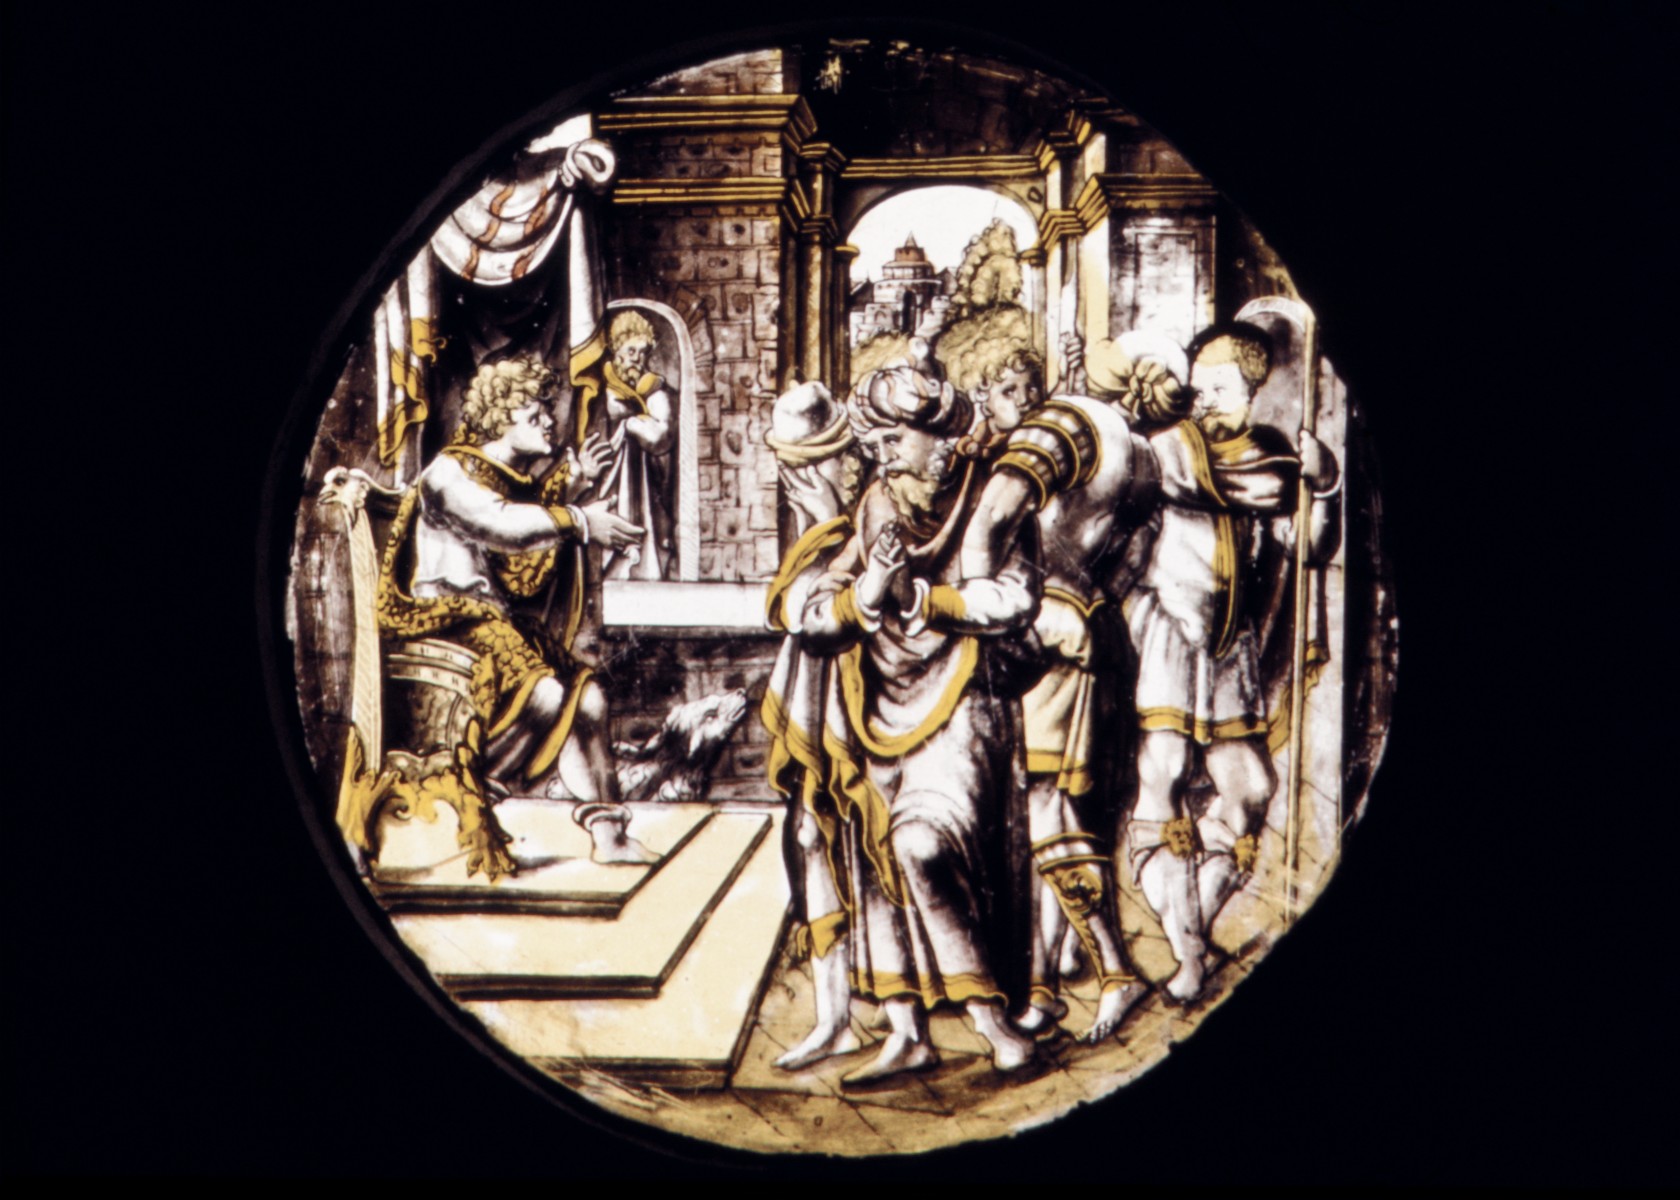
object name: roundel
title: Joseph Making Himself Known to His Brethren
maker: jan swart van groningen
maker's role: maker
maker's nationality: netherlandish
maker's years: 1490-1553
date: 1535-1540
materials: glass